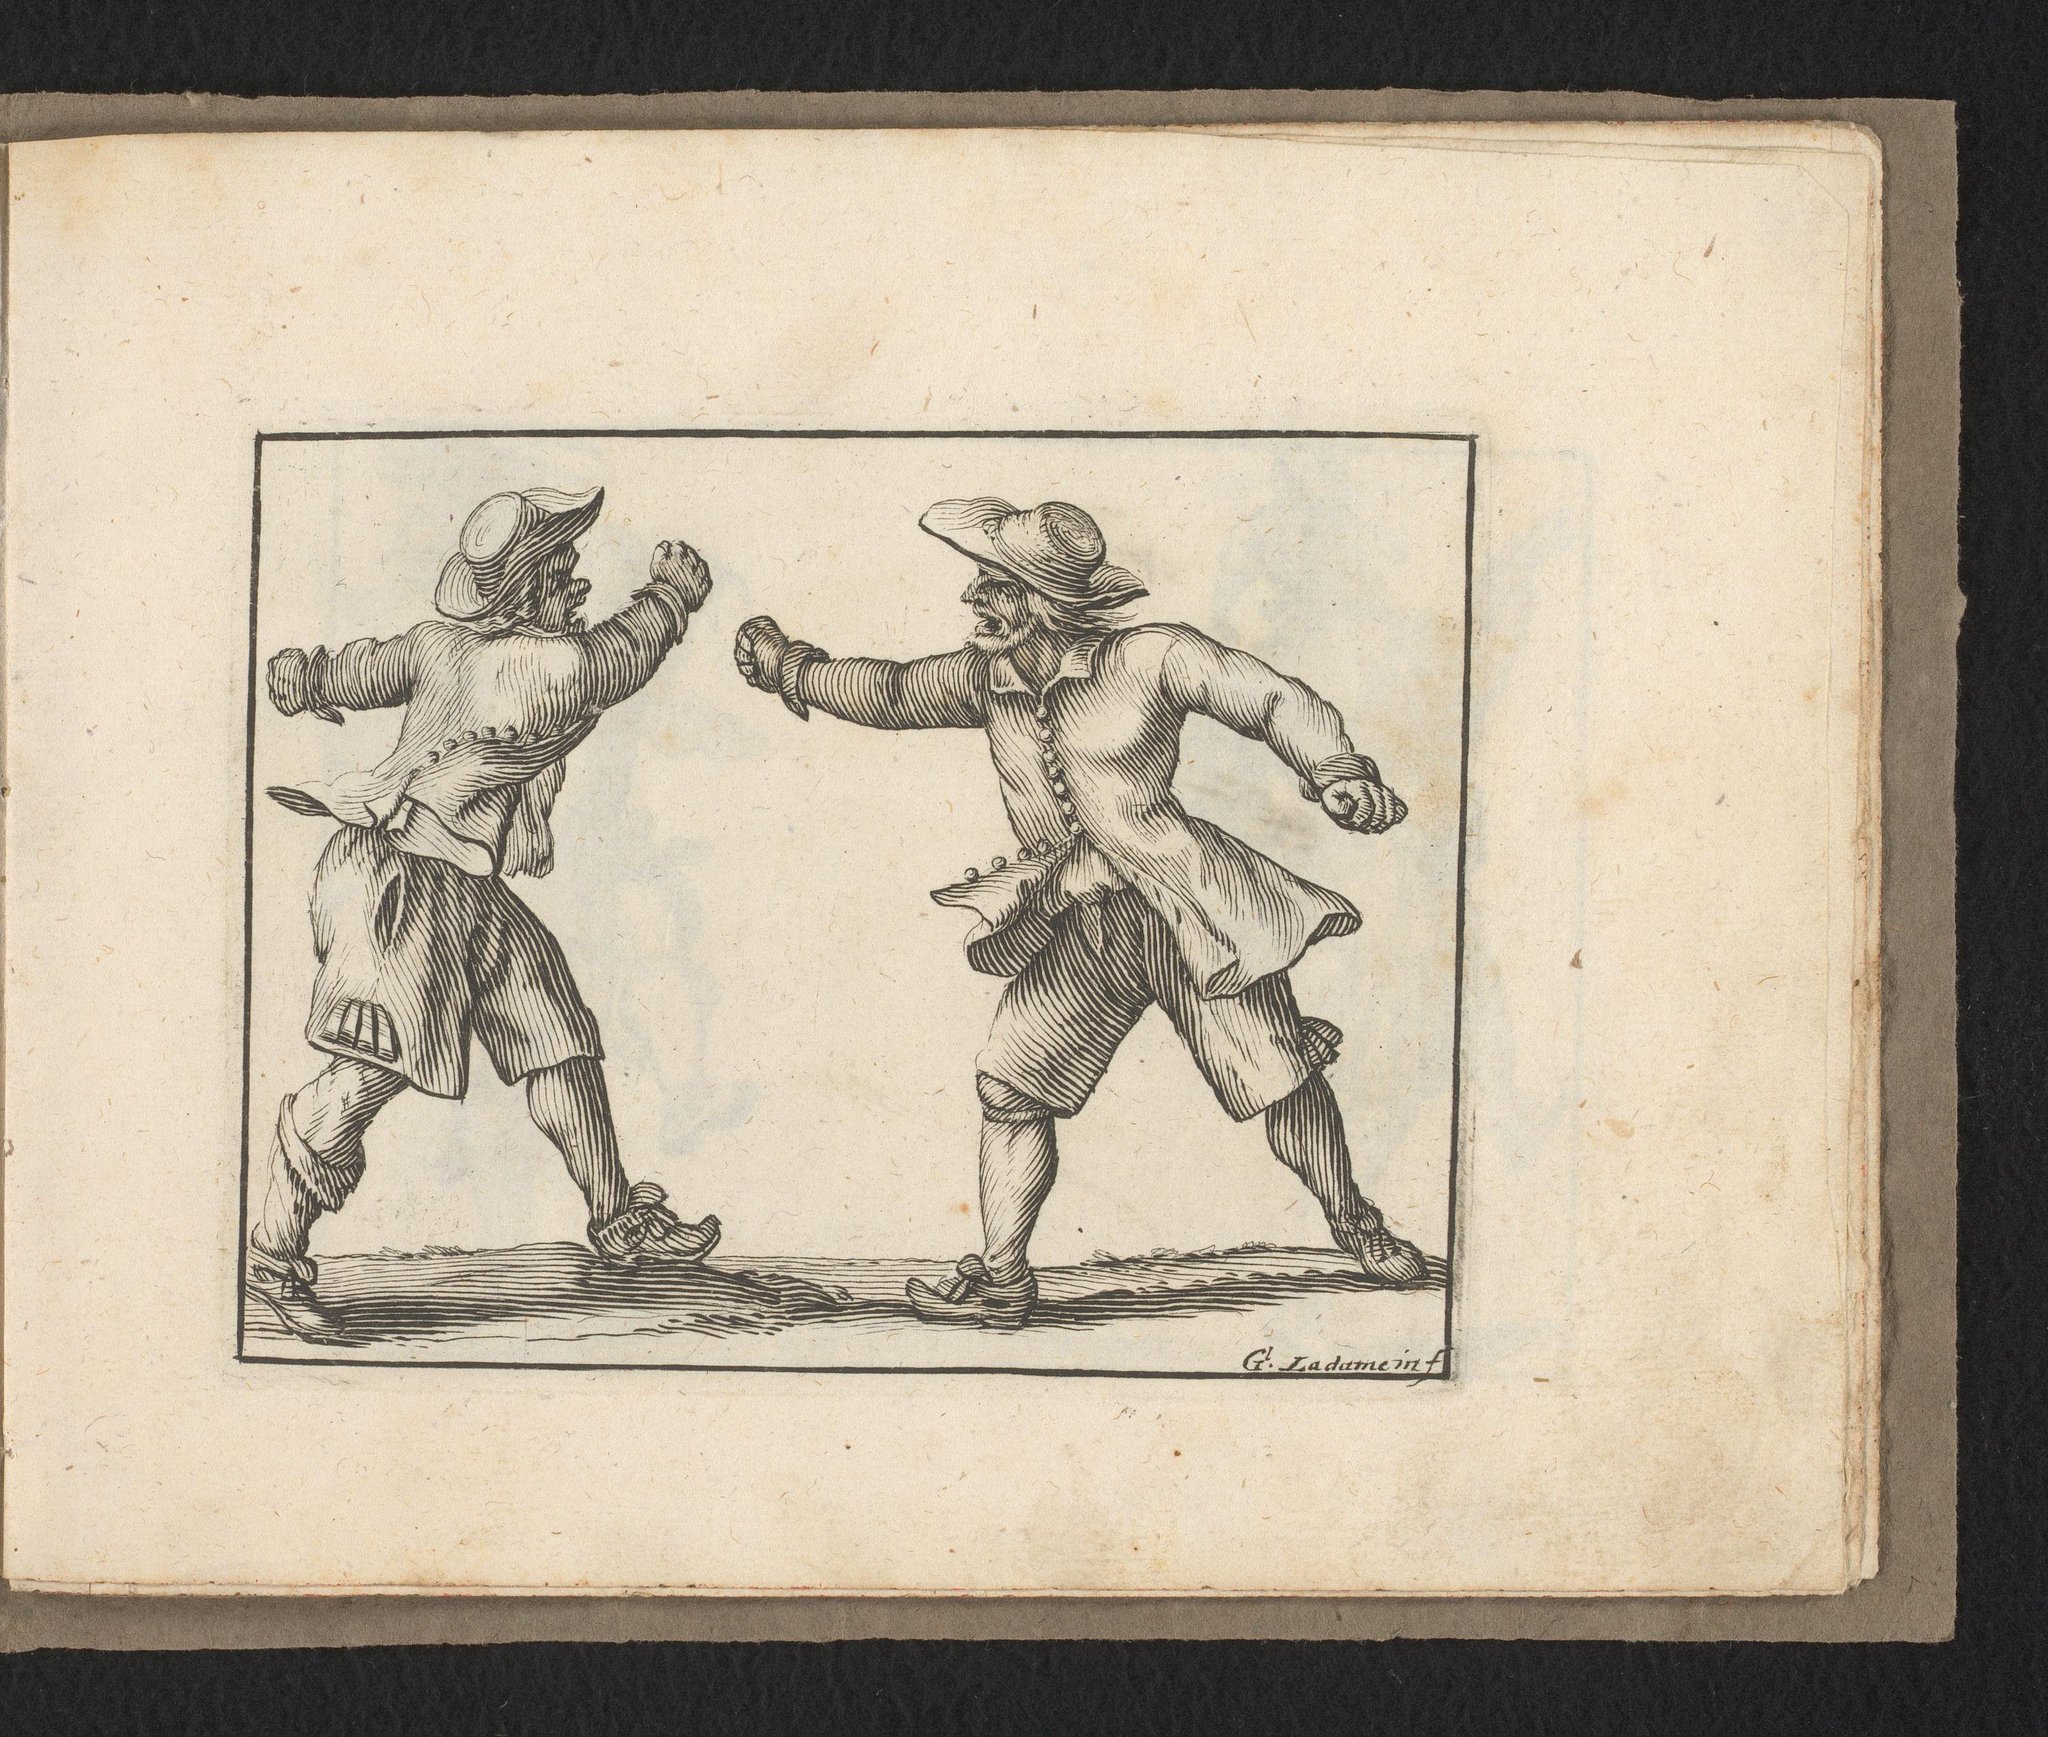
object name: album leaf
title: Twee vechtende mannen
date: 1660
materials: paper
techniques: etching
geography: paris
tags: farmers, fist-fight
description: Deze prent maakt deel uit van een album.